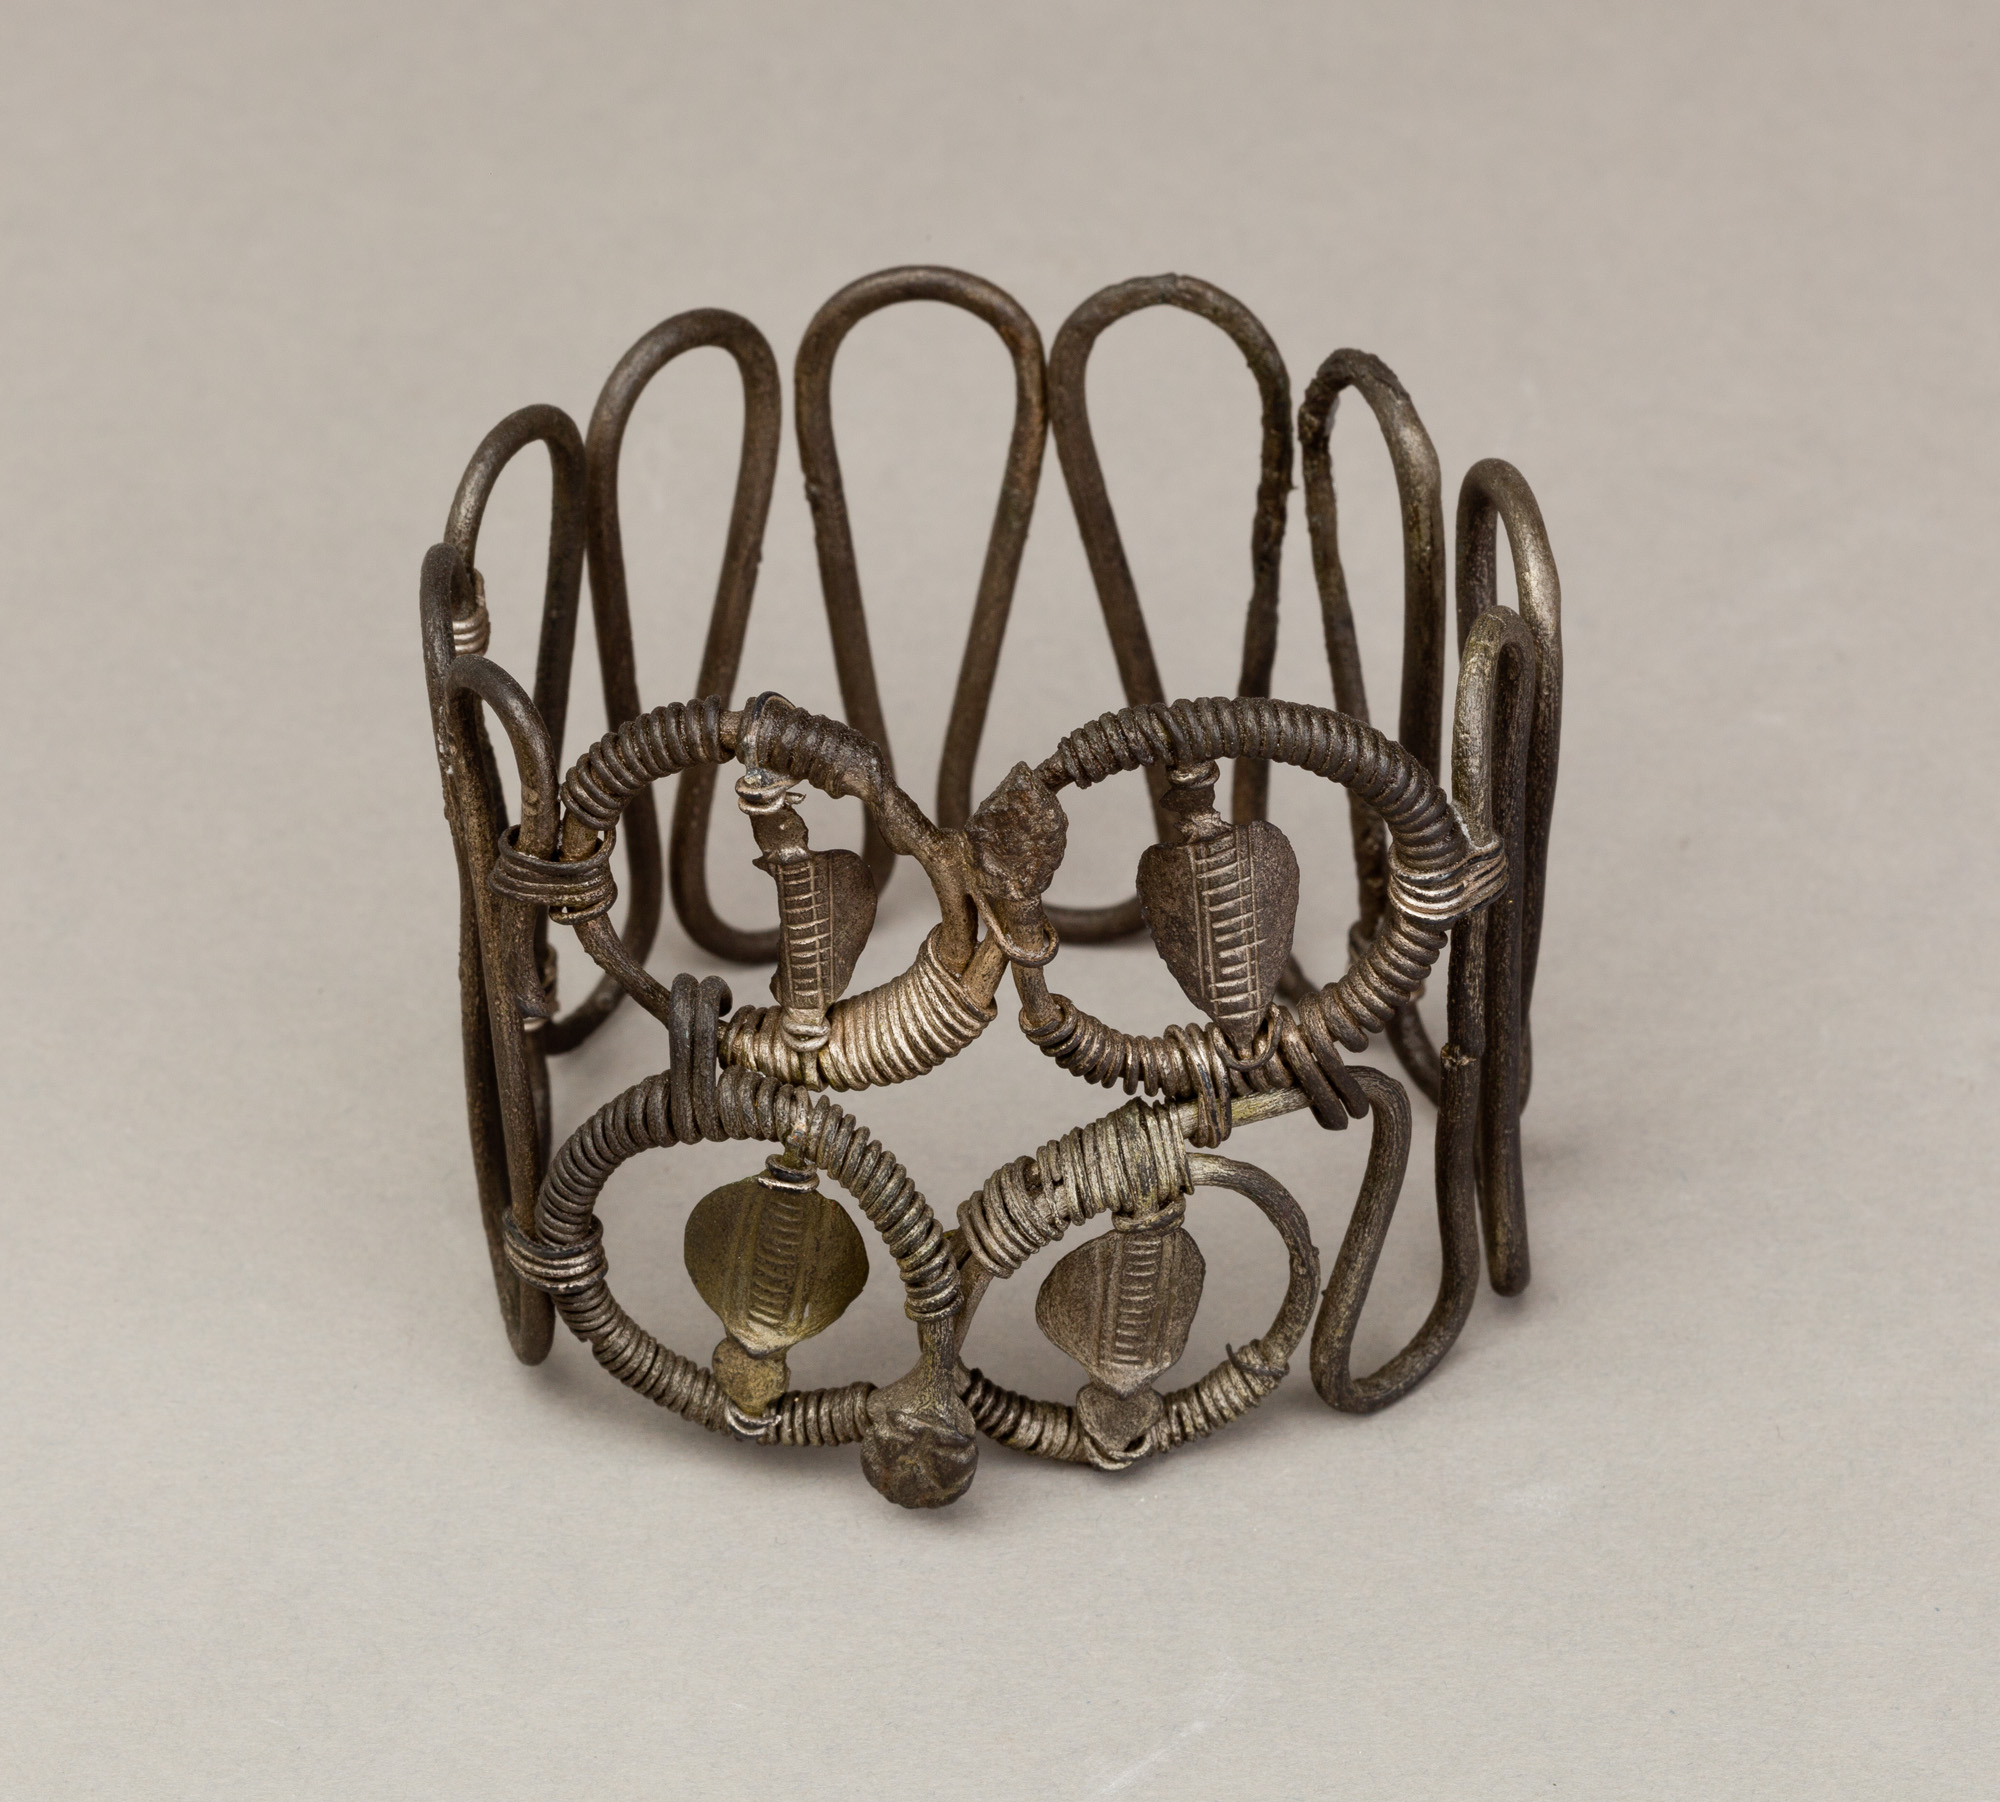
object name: bracelet or armlet, uraei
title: Bracelet or armlet with uraei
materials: silver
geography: egypt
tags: serpents